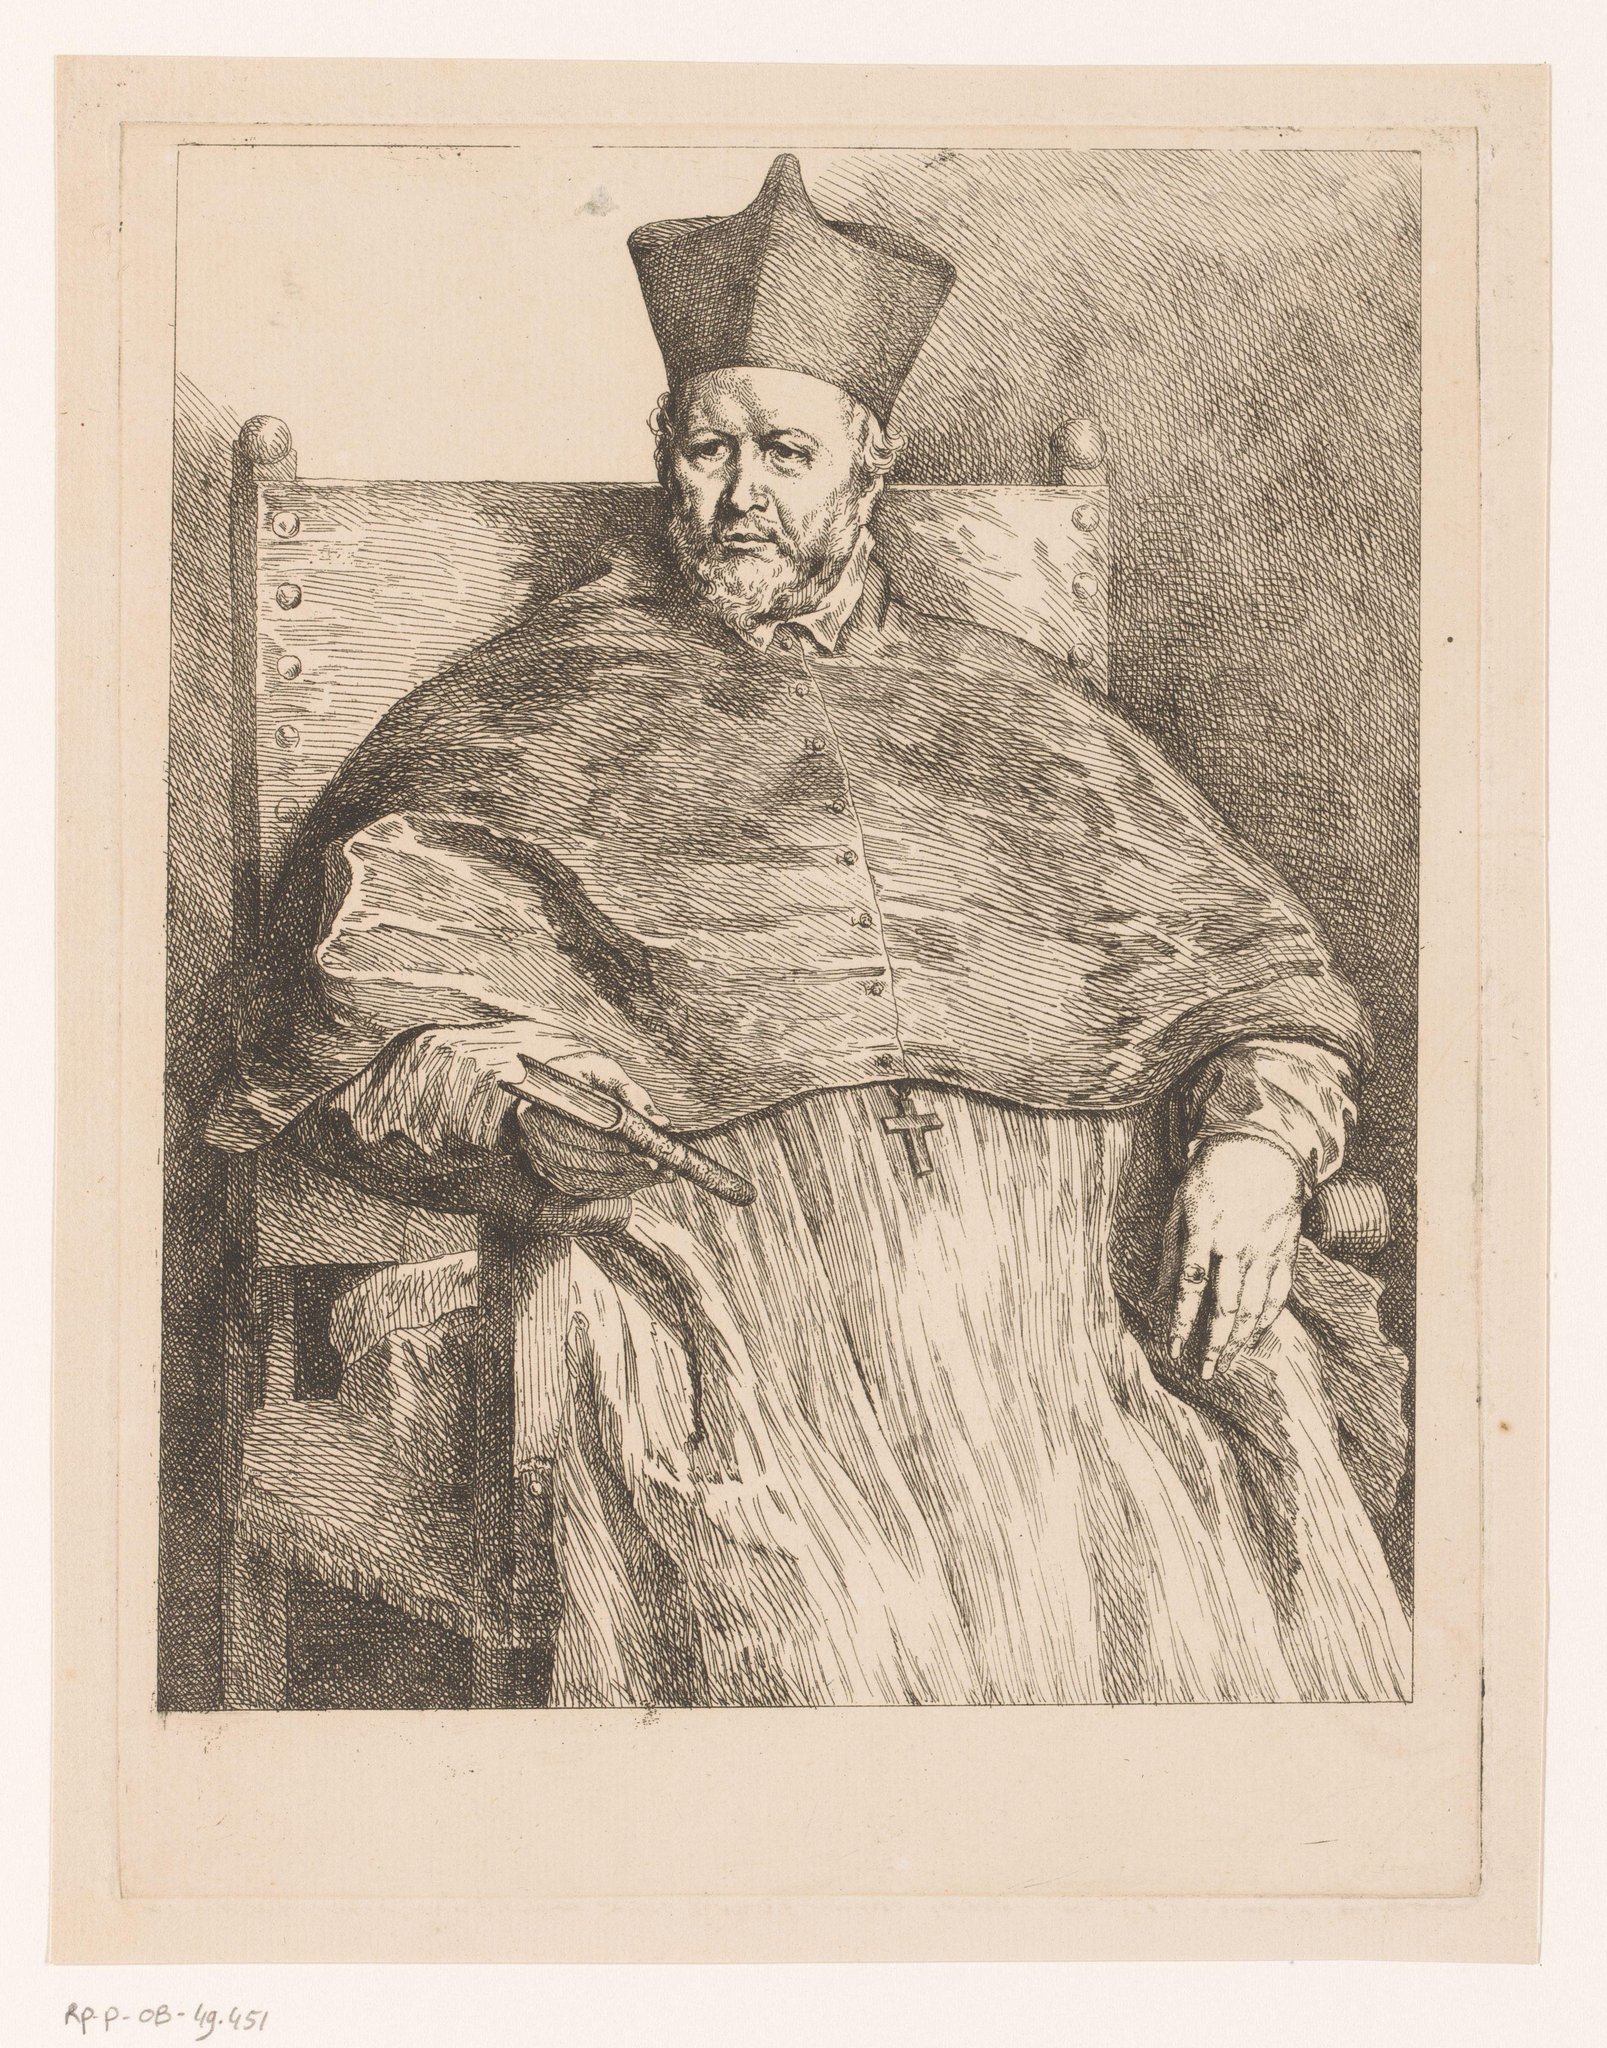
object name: print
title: Portret van bisschop Johannes Malderus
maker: andreas bernardus de quertenmont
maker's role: draughtsman, print maker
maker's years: 1750-1835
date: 1779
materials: paper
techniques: etching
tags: johannes malderus, armchair, seat, archbishop, bishop, etc. (roman catholic), historical persons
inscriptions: collector's mark: Lugt 240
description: Malderus (geboren Jan van Malderen) was de vijfde bisschop van Antwerpen.